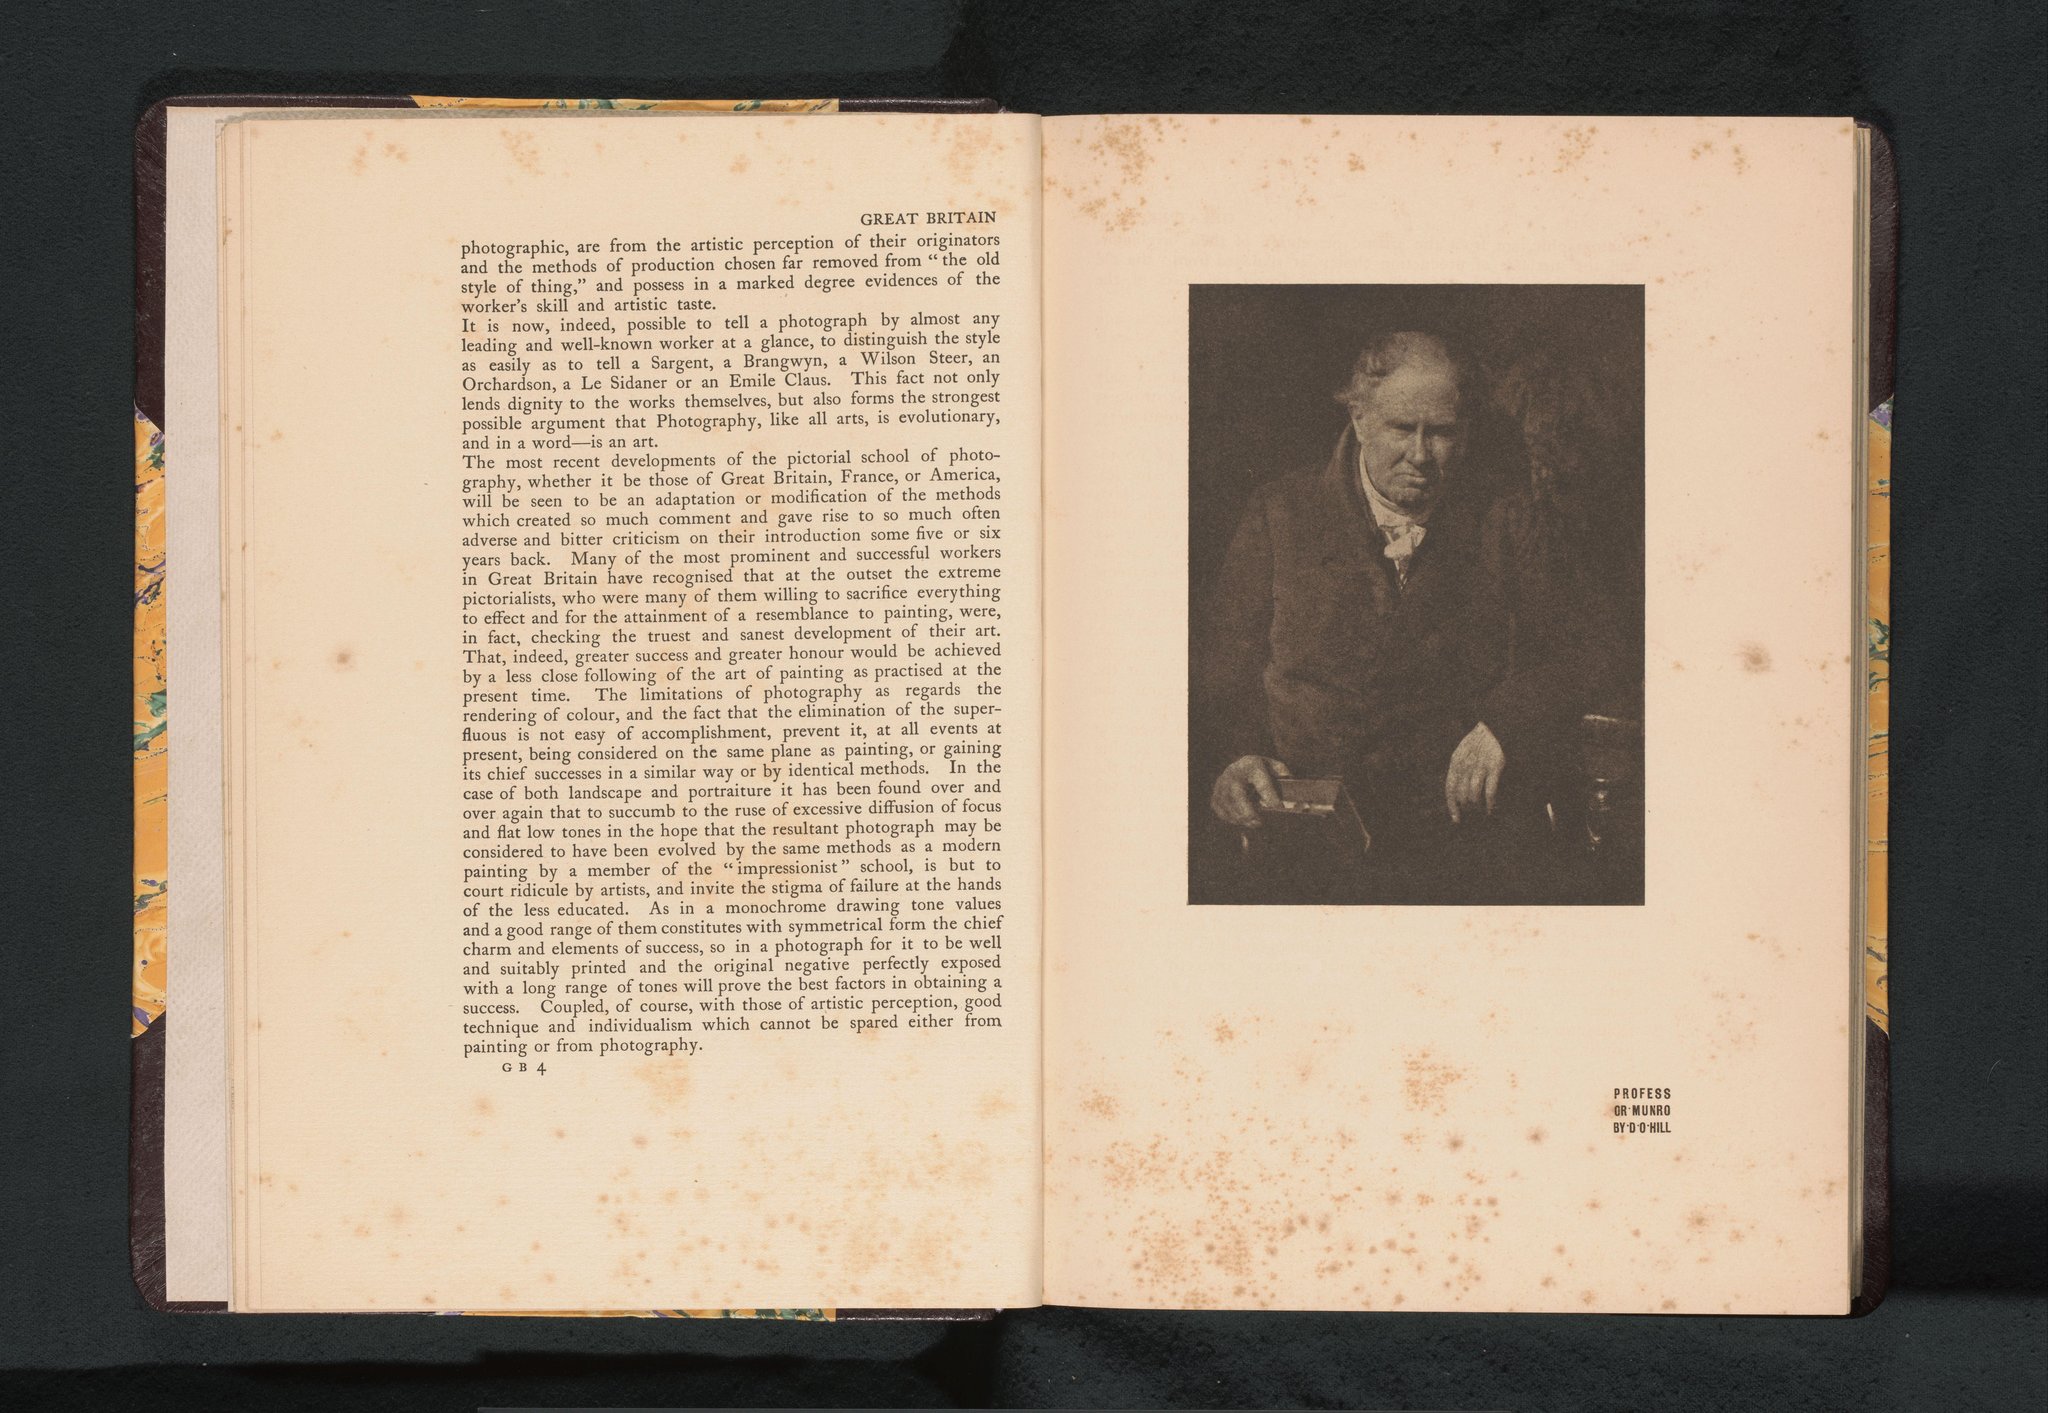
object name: page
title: Portret van Dr. Alexander Monro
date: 1900-1905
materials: paper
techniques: autotype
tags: historical persons